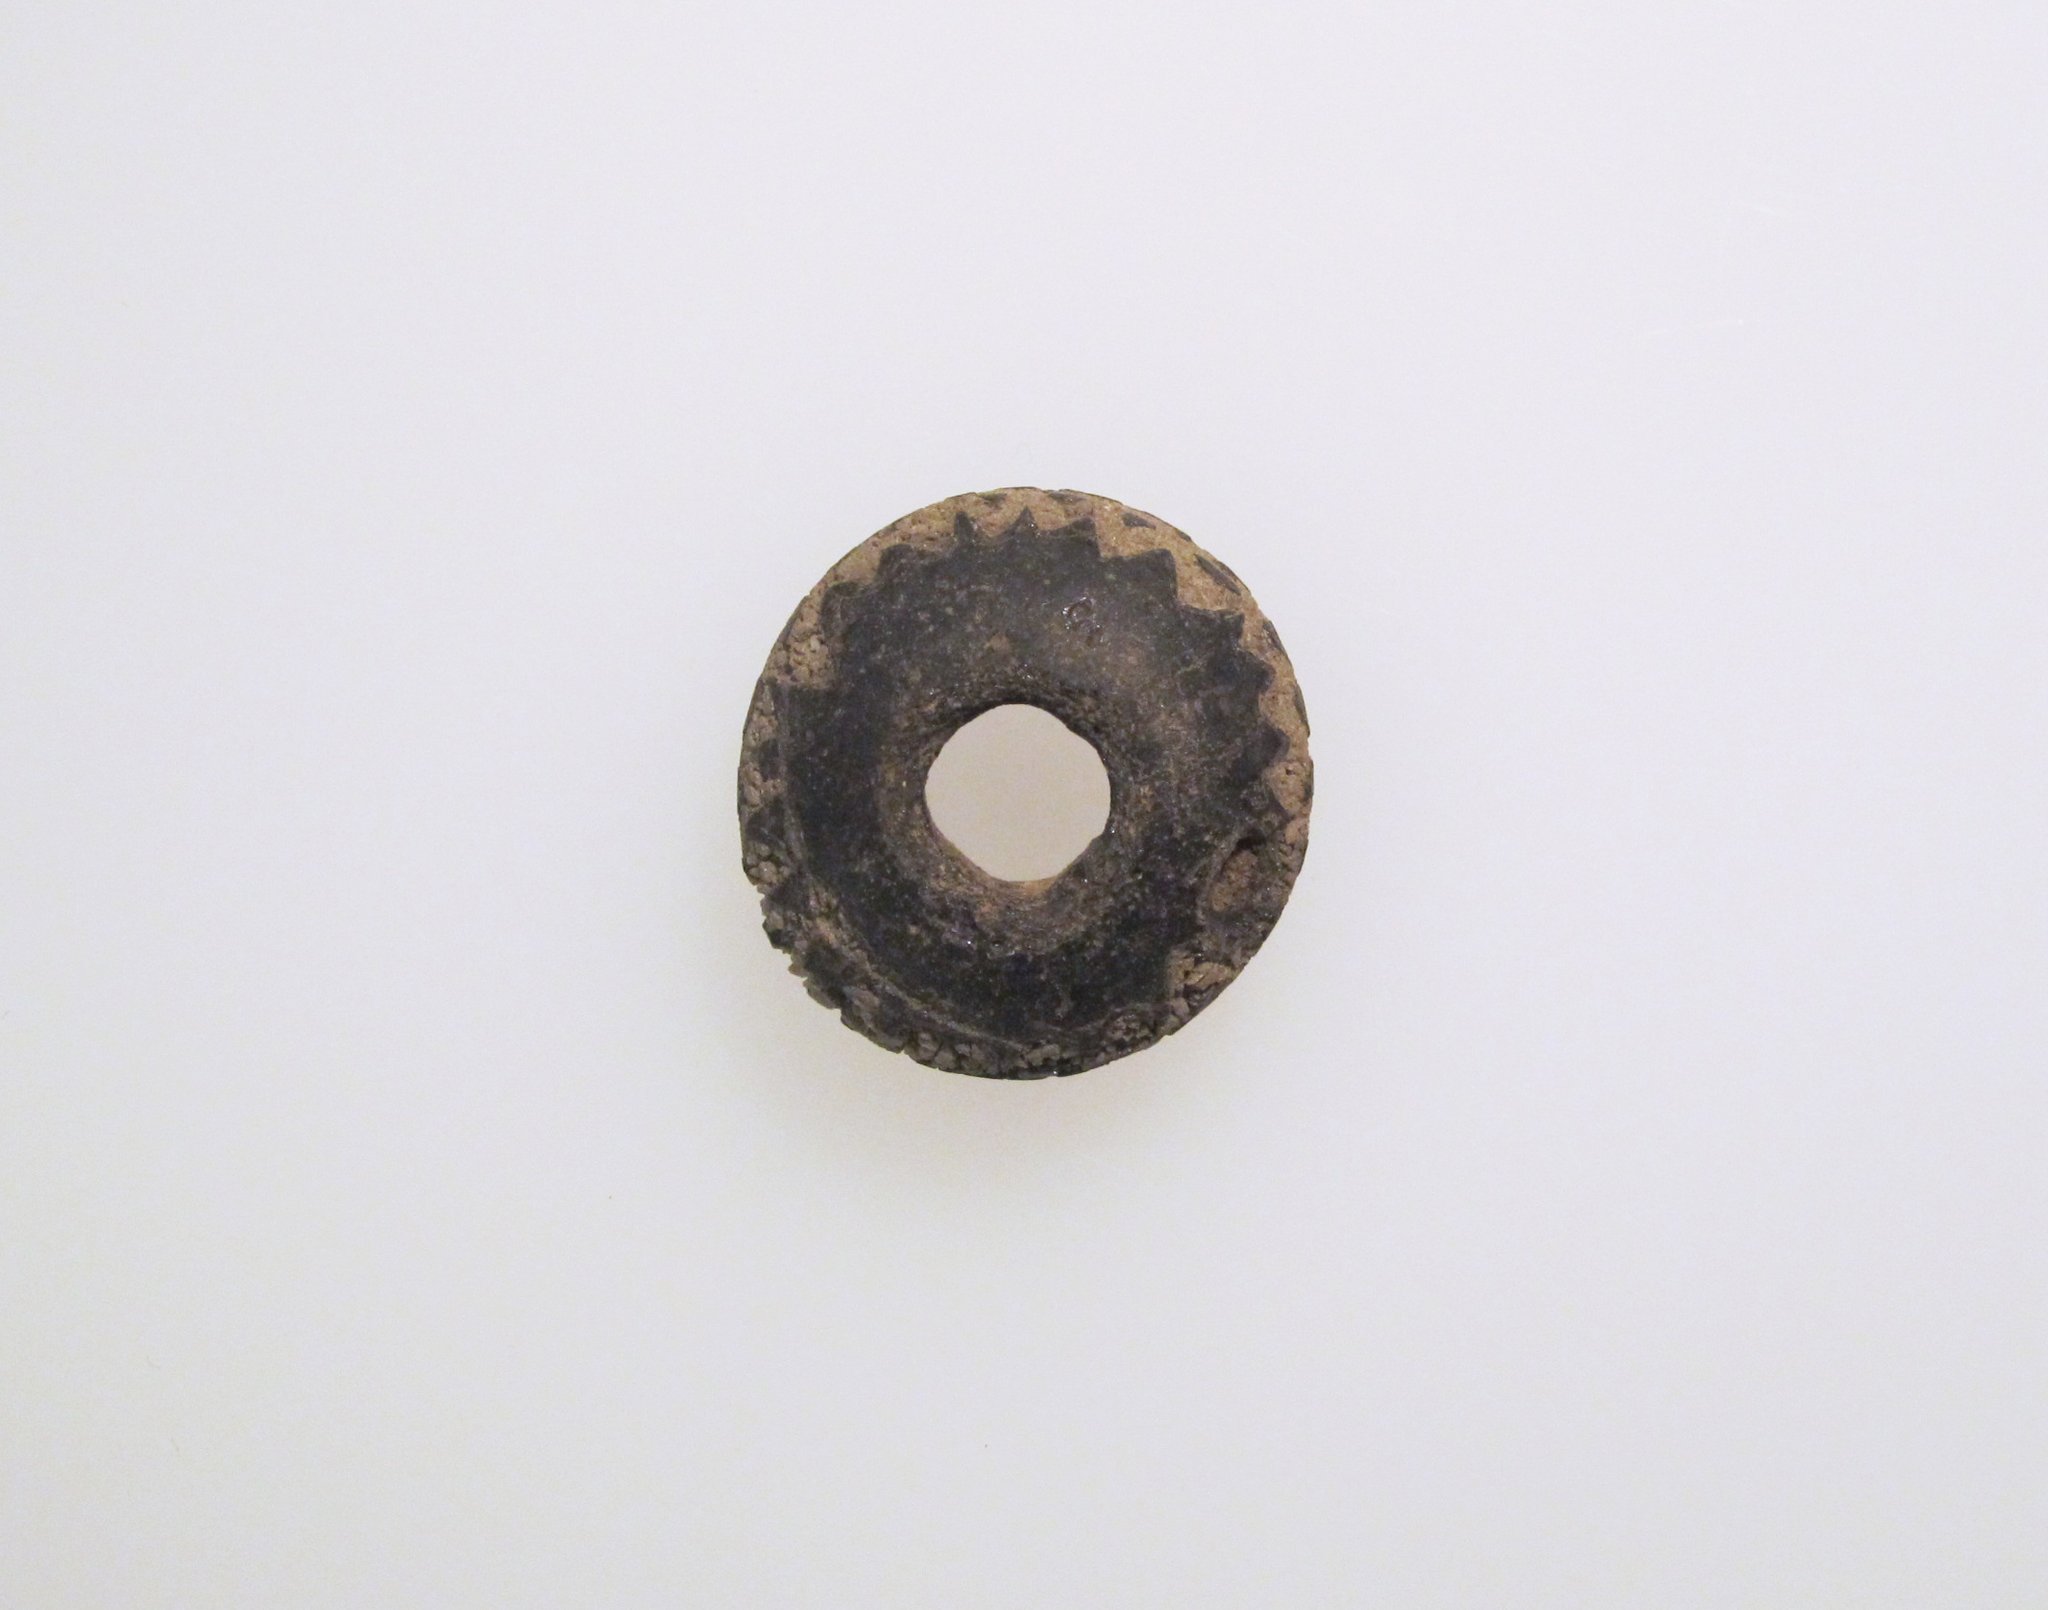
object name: bead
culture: roman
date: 670 BCE-330 CE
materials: glass